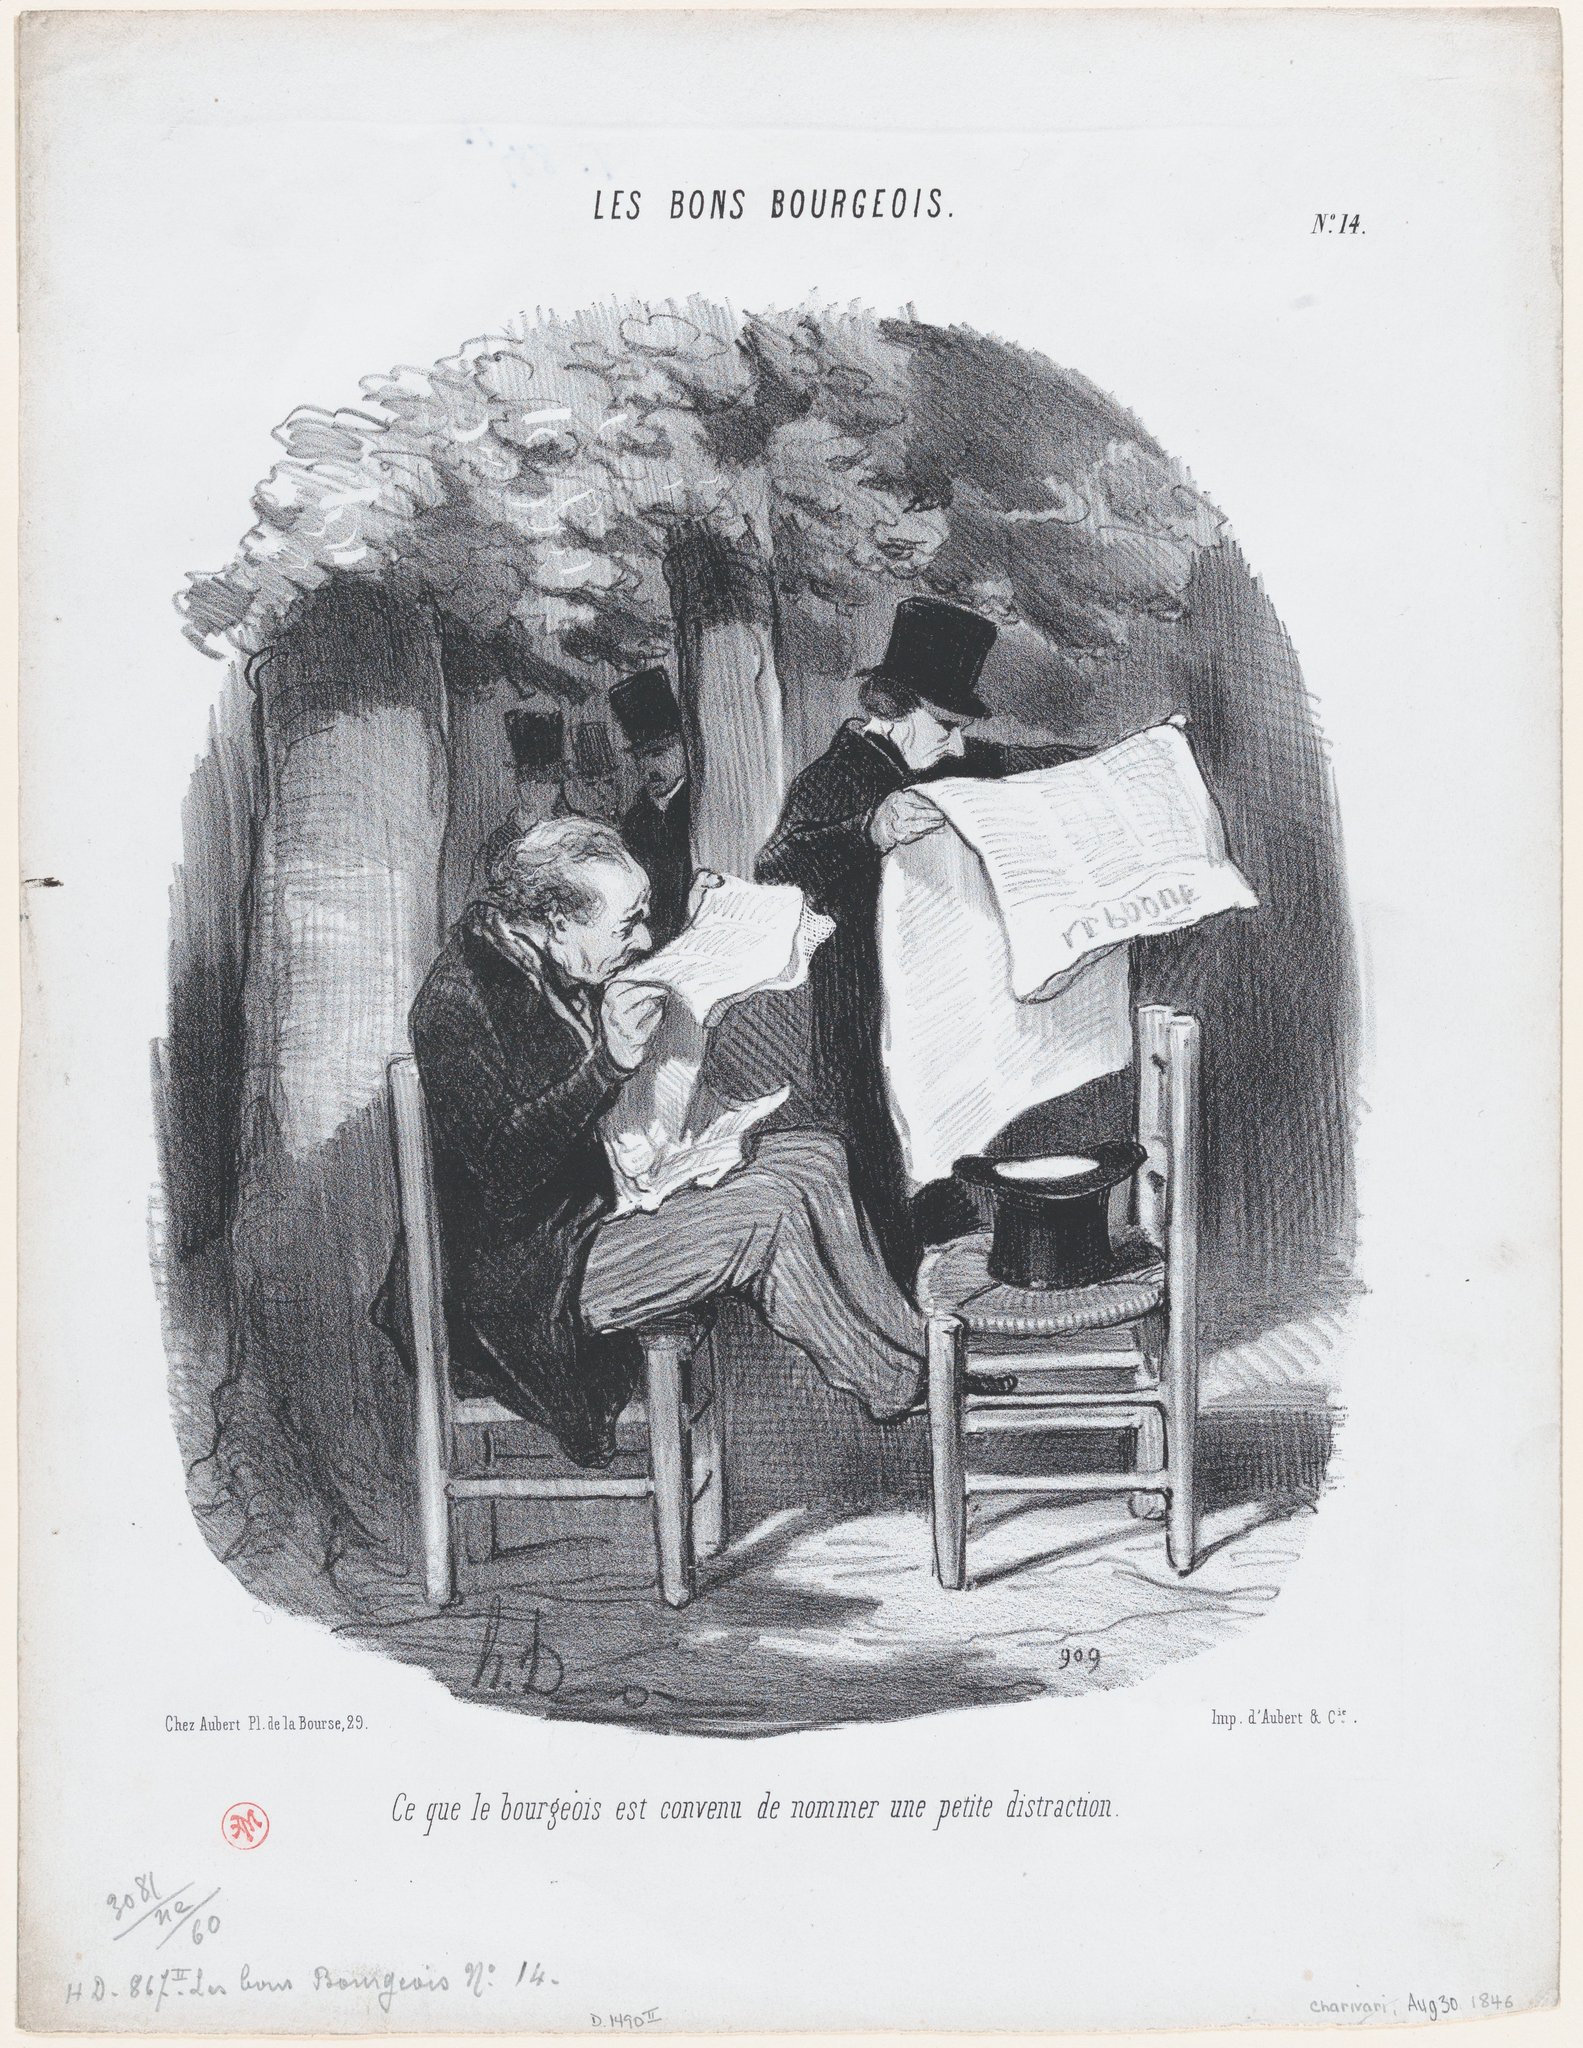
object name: print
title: What the bourgeois calls a slight distraction, from 'The good bourgeois,' published in "Le Charivari"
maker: honoré daumier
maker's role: artist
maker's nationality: french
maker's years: 1808-1879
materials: paper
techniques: lithograph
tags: hats,men,reading,trees,chairs